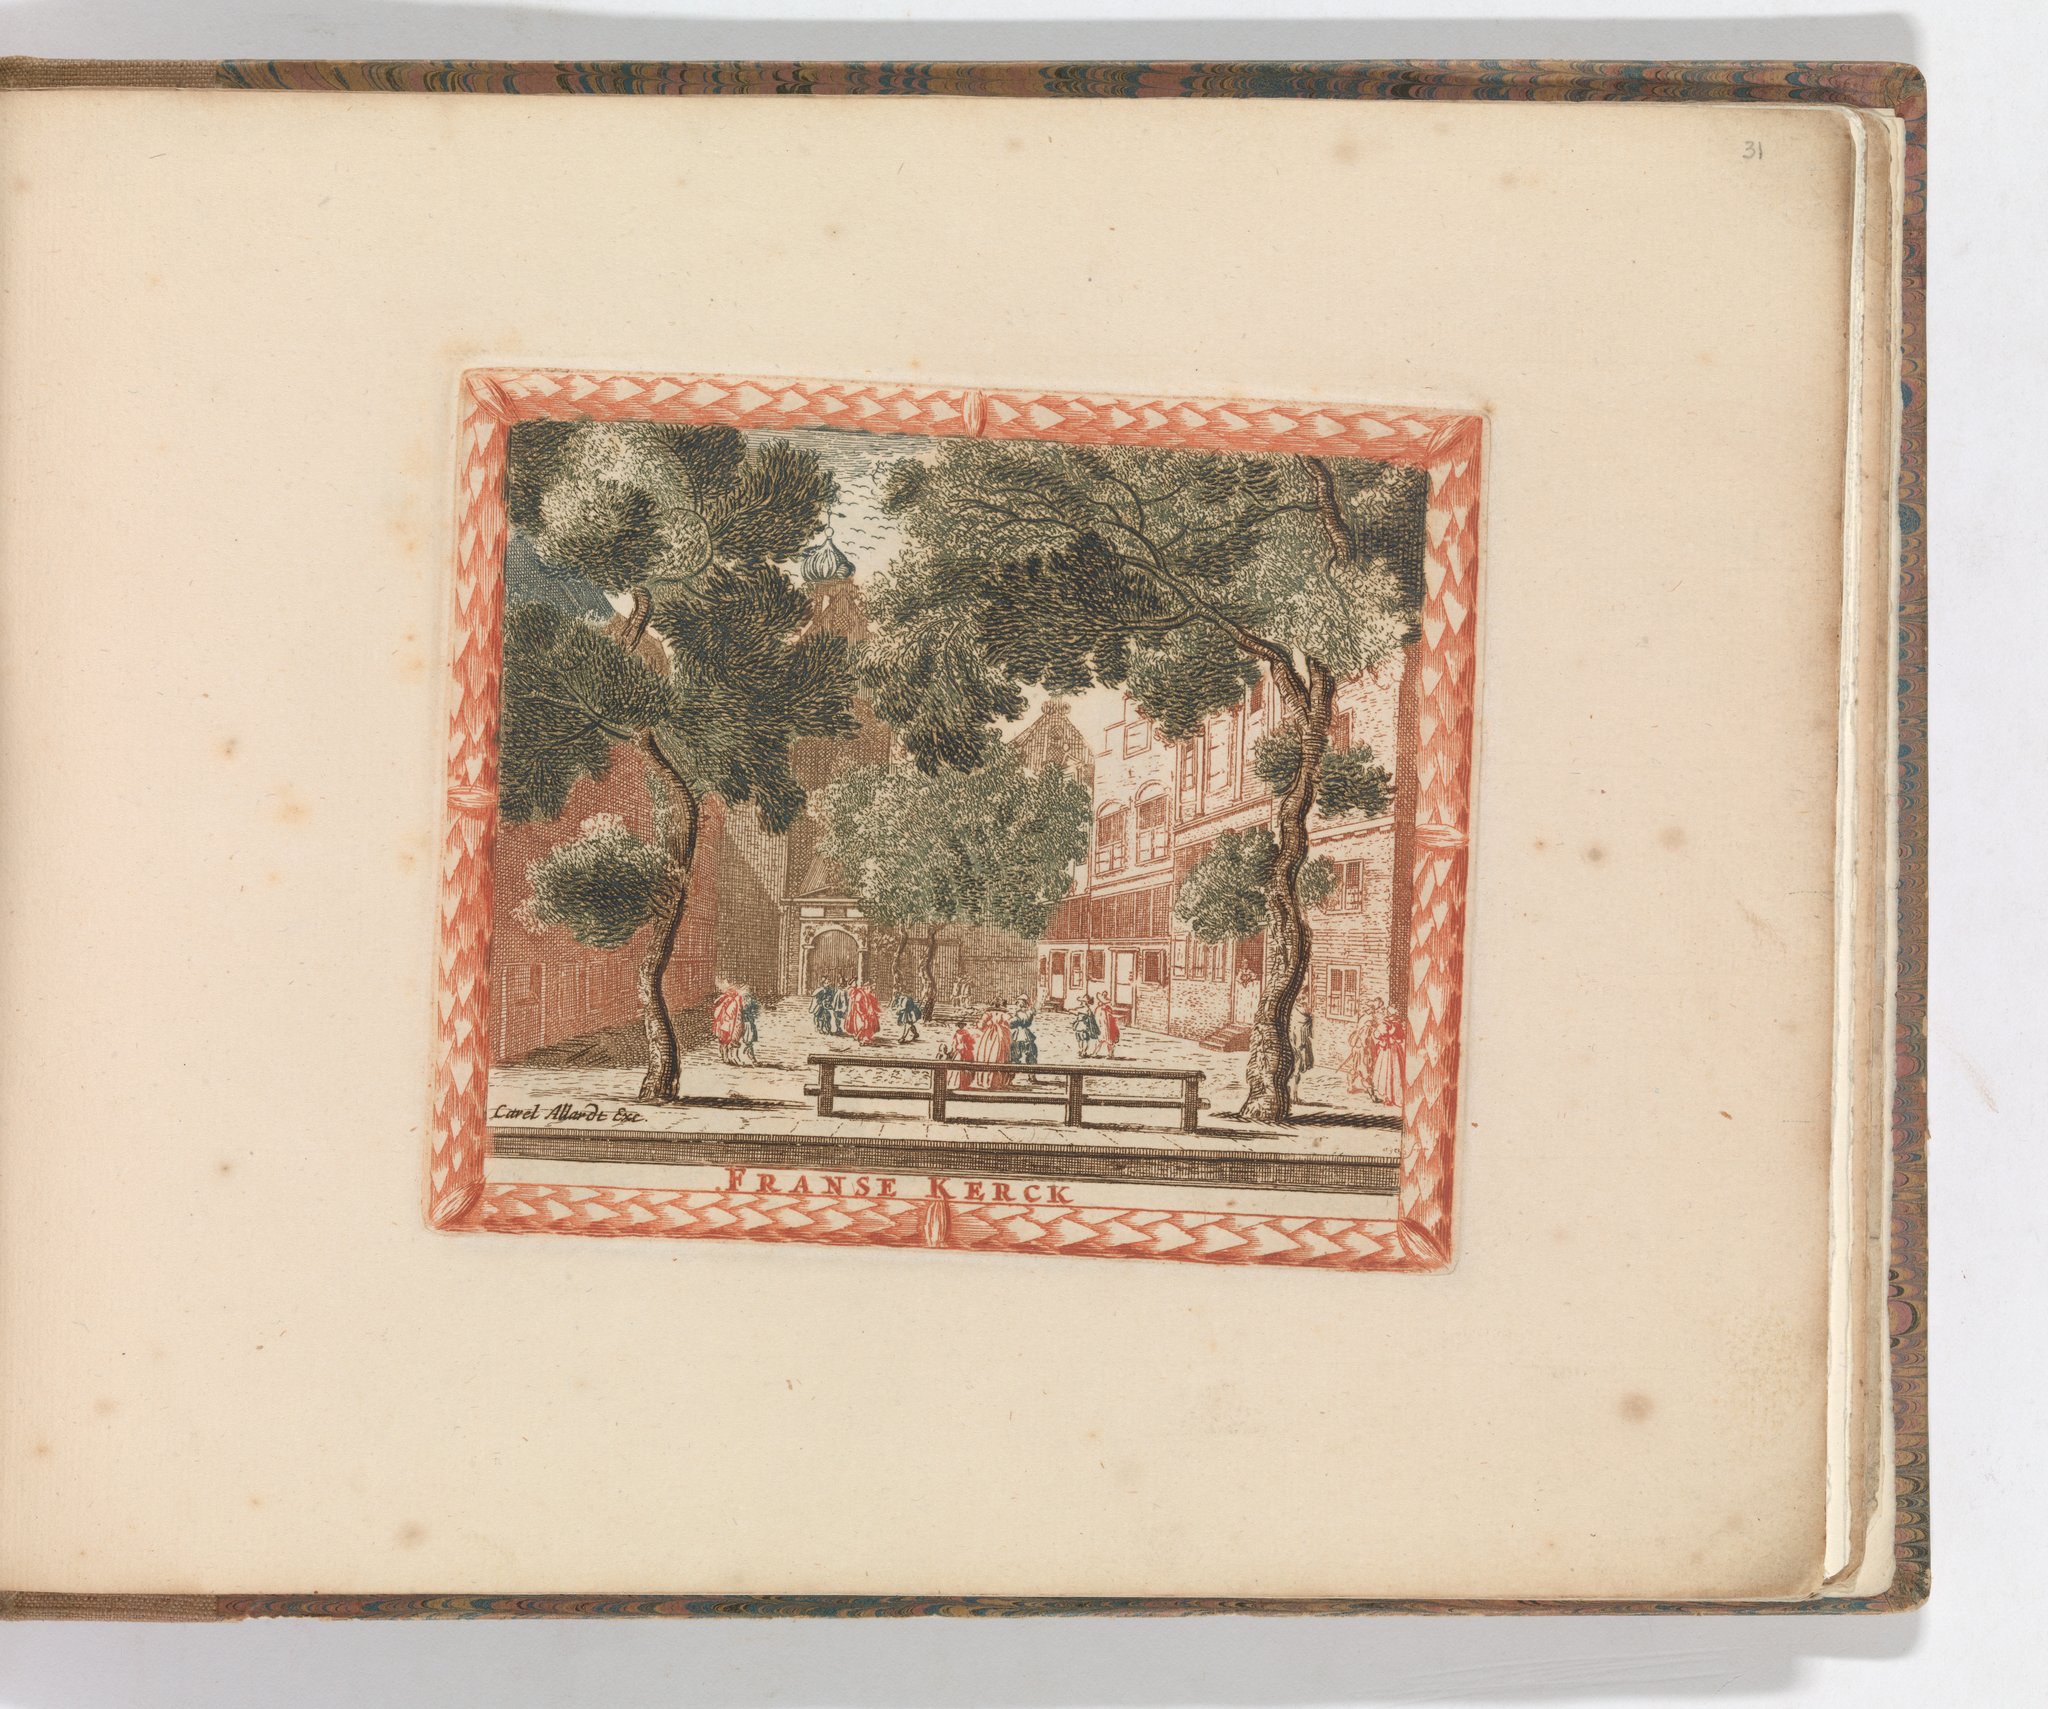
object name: book print ornament architecture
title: 'Franse Kerck', in: Tooneel Der Voornaamste Nederlands Huizen, En Lust Hoven, Naar T Leven Afgebeeld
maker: carel allard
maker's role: publisher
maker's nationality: dutch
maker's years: 1648-1709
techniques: engraving, lithography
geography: amsterdam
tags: palaces,men,women